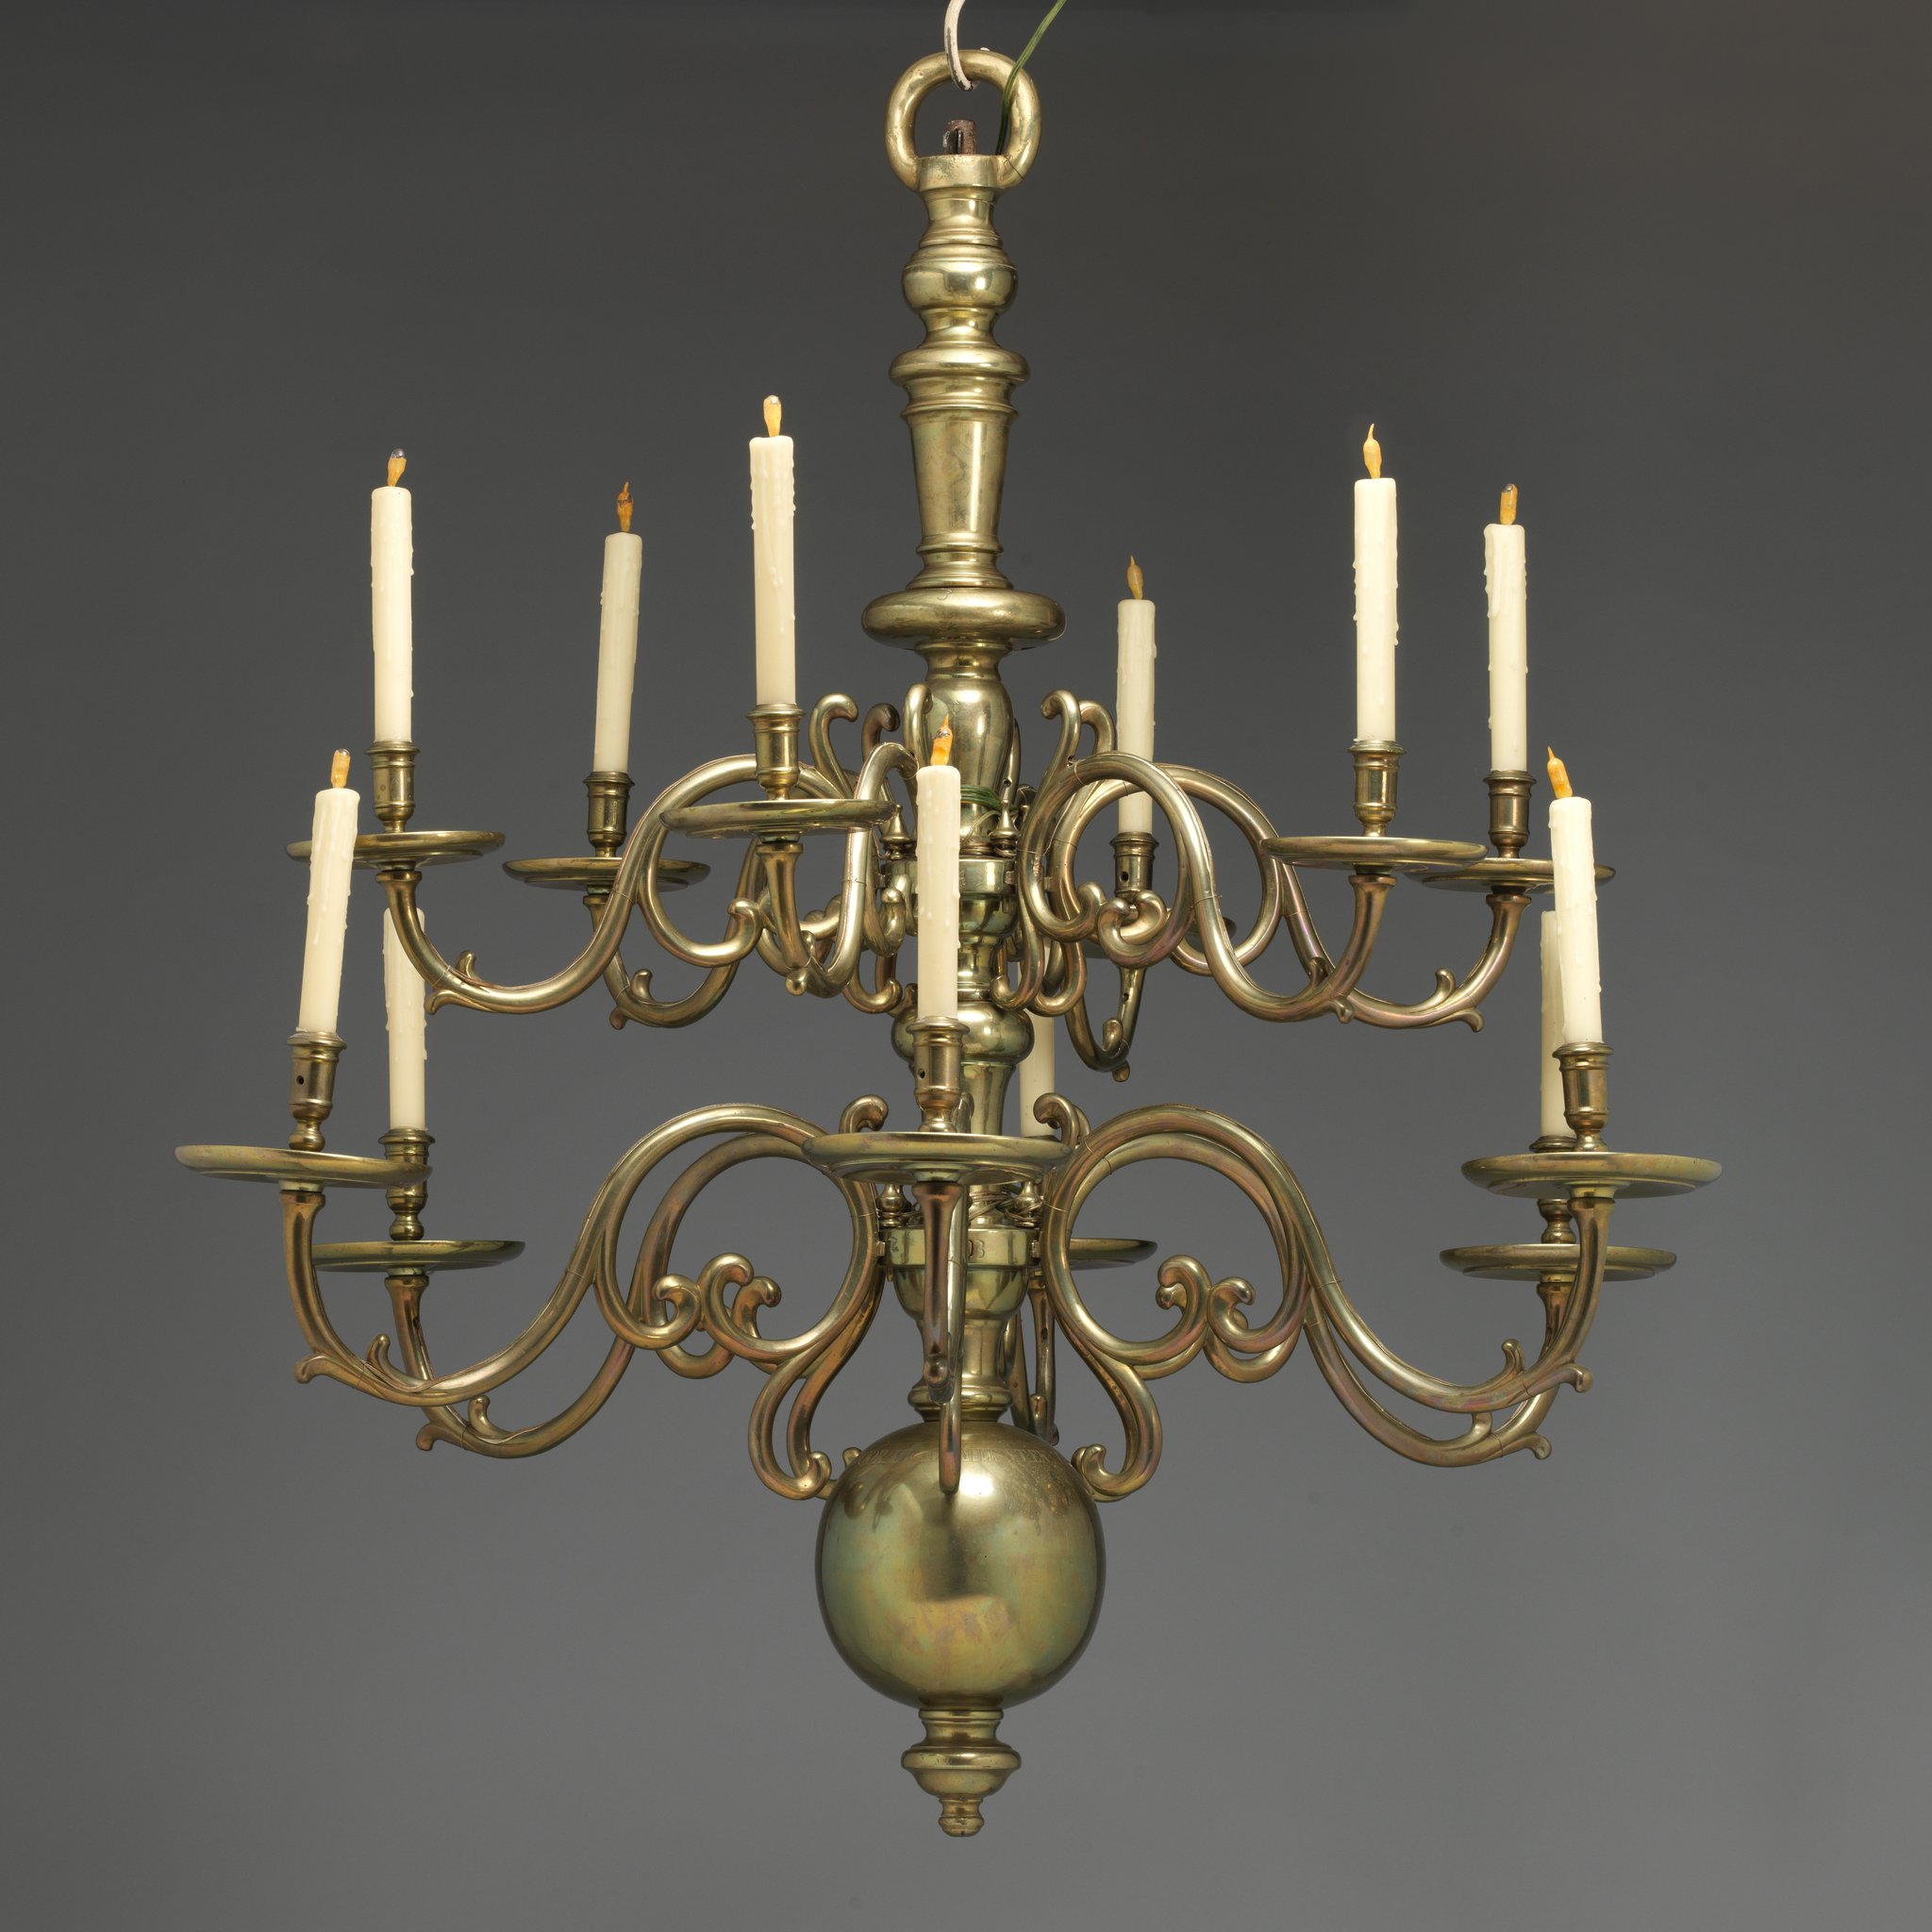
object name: chandelier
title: Church chandelier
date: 1734-1766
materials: brass